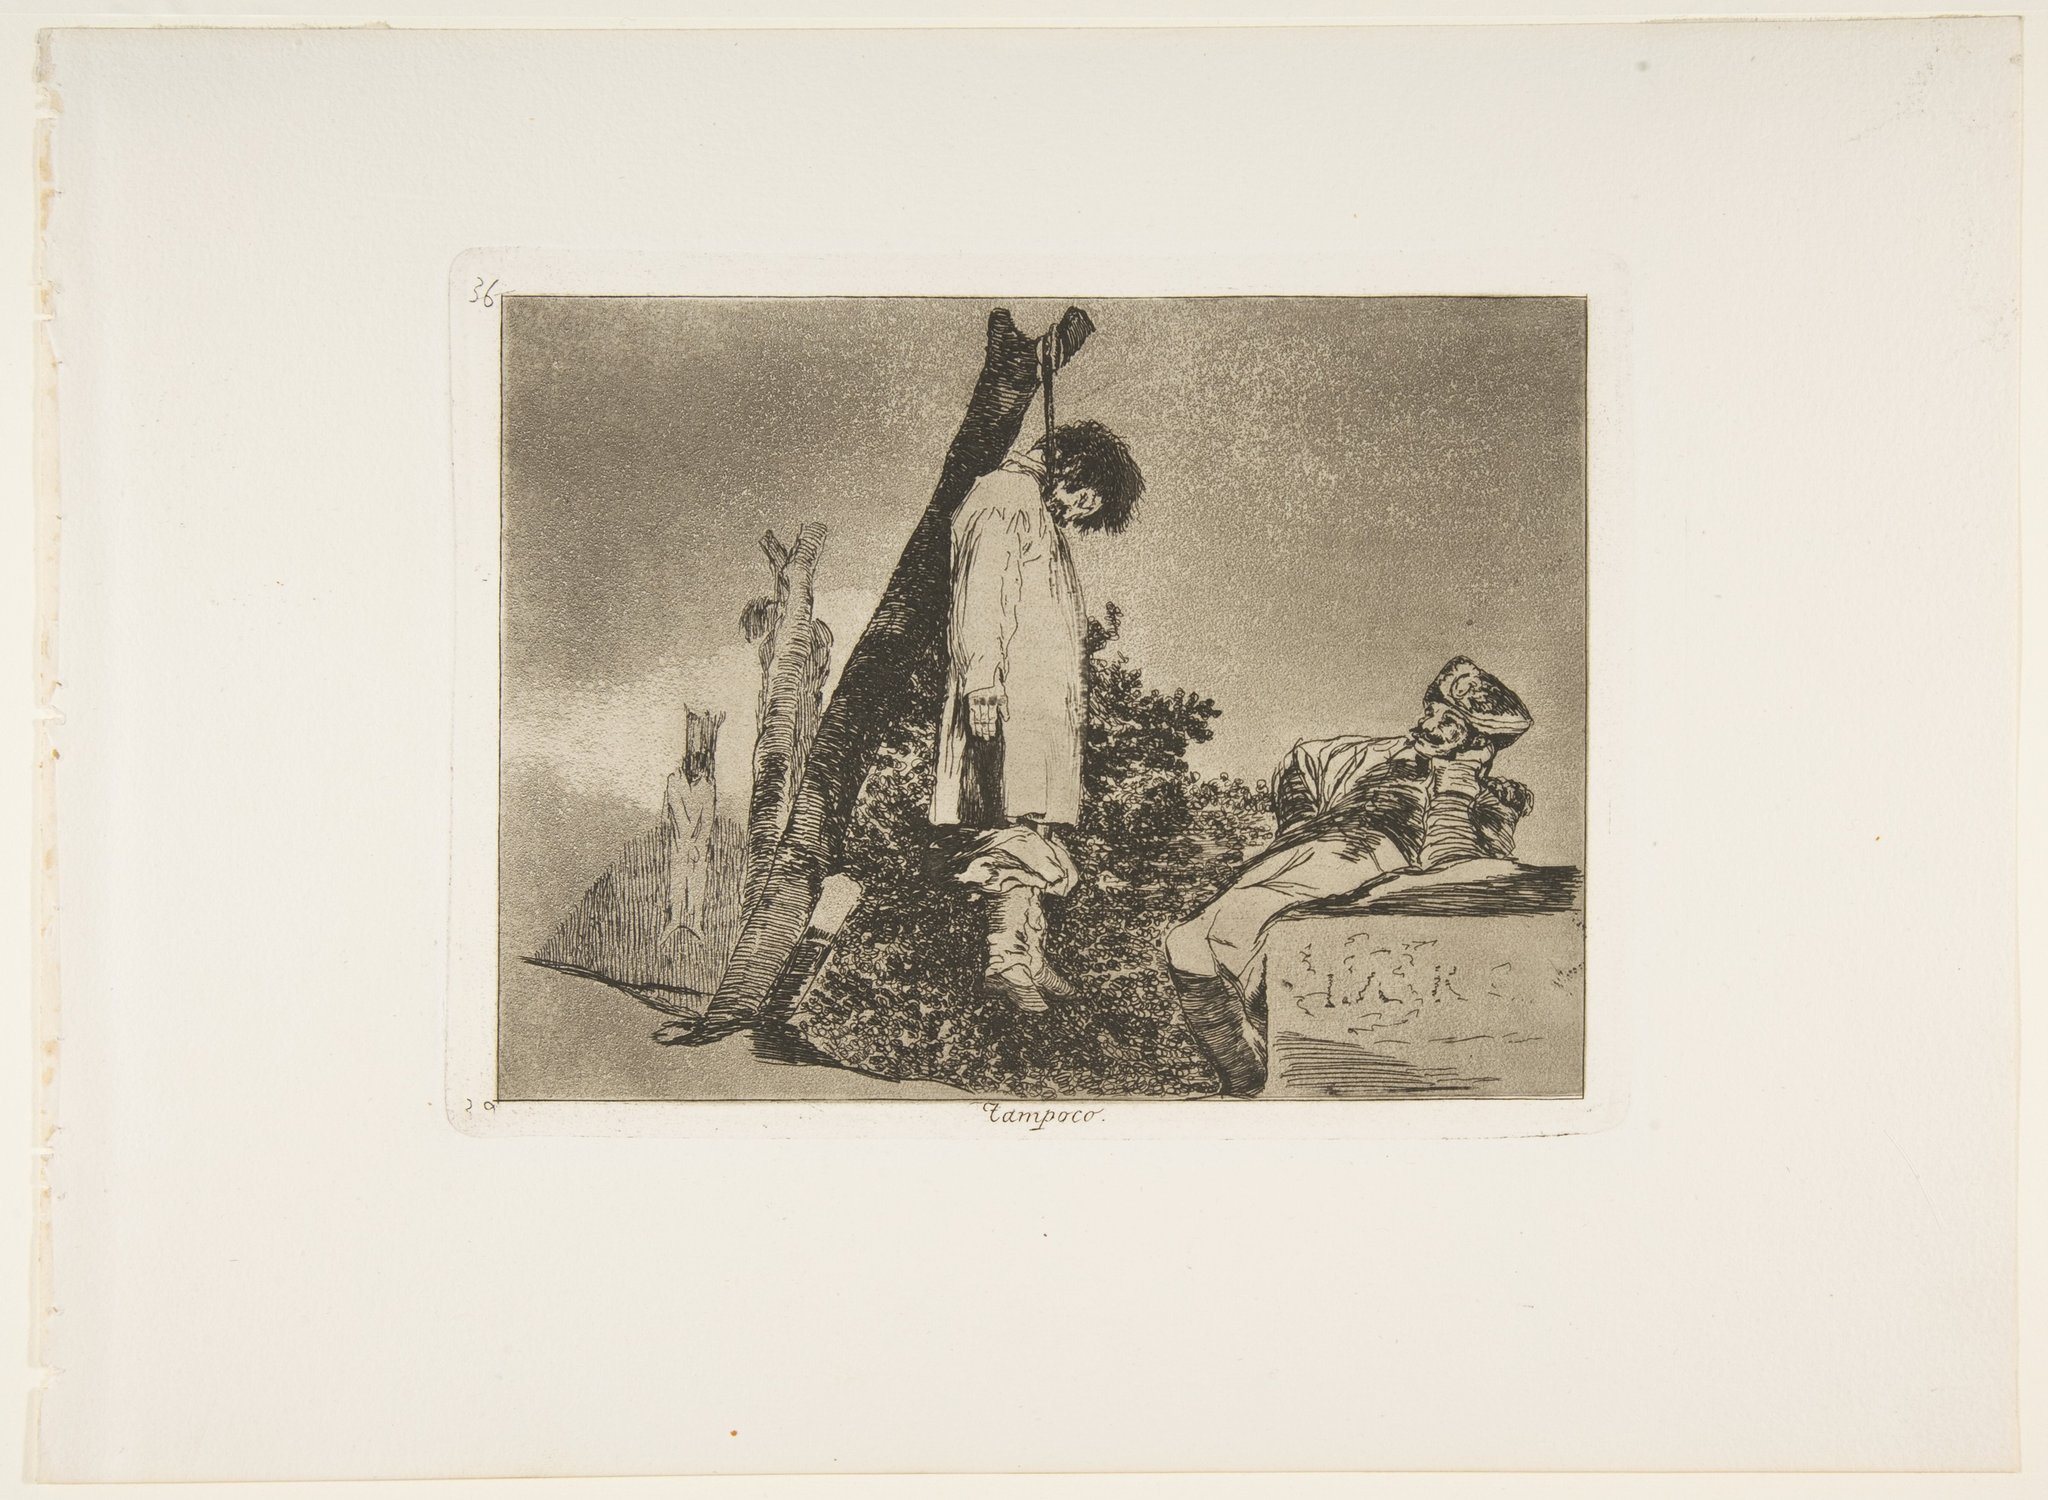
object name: print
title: Plate 36 from "The Disasters of War" (Los Desastres de La Guerra): 'Not [in this case] either' (Tampoco)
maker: goya (francisco de goya y lucientes)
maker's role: artist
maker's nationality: spanish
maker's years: 1746-1828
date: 1810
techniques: aquatint, engraving, burnishing, drypoint, etching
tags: men,death,punishment